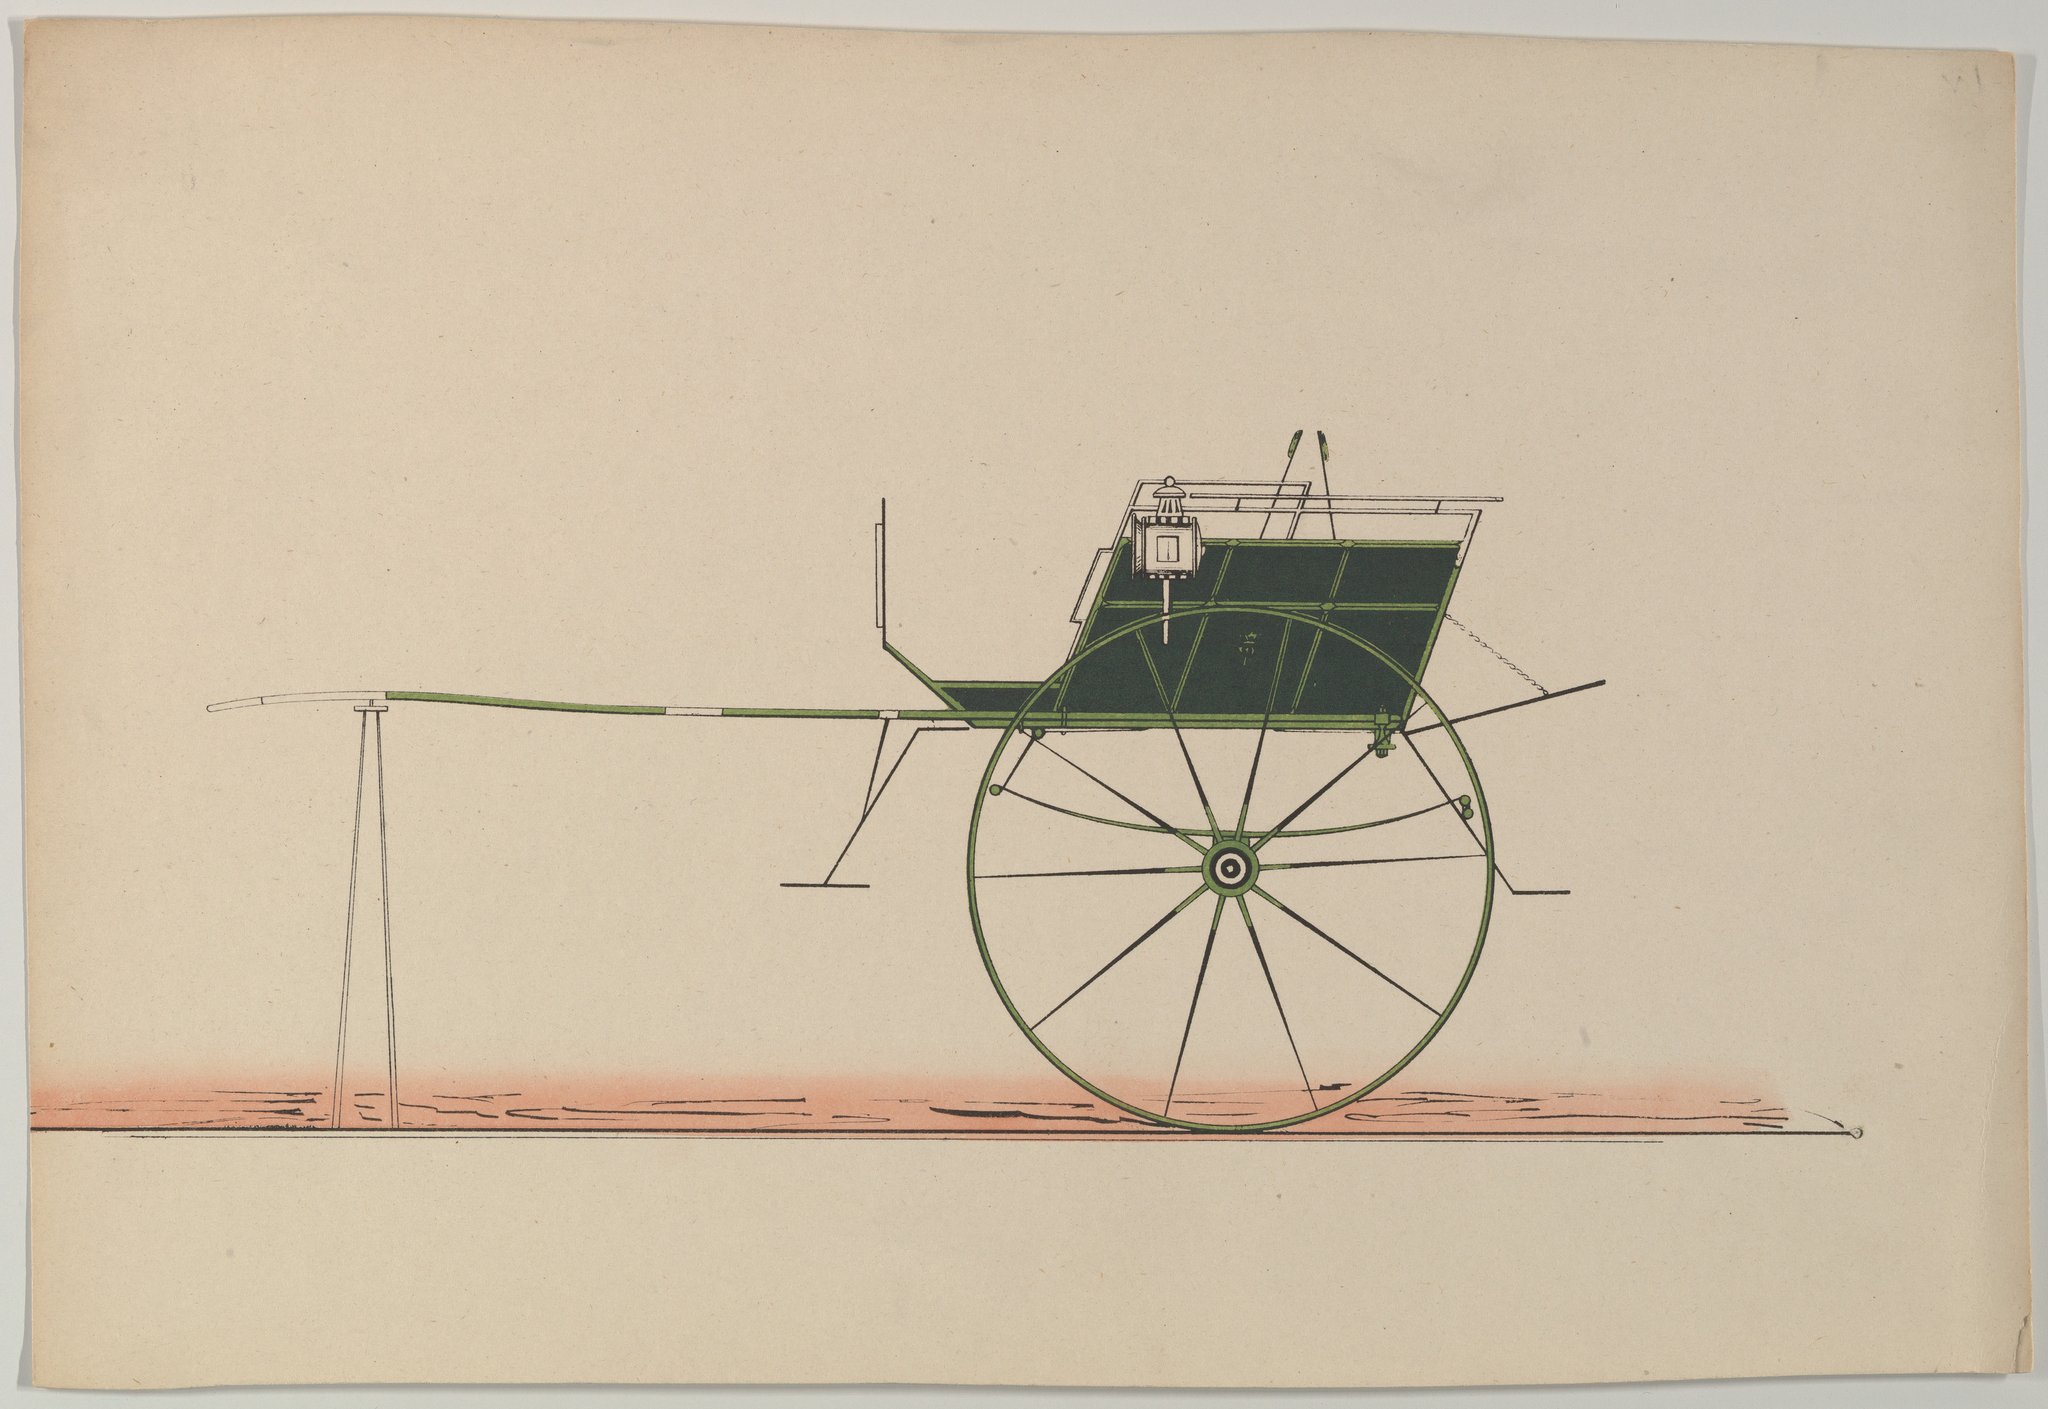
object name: print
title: Whitechapel Cart (unnumered)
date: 1850-1874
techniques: engraving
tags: carriages